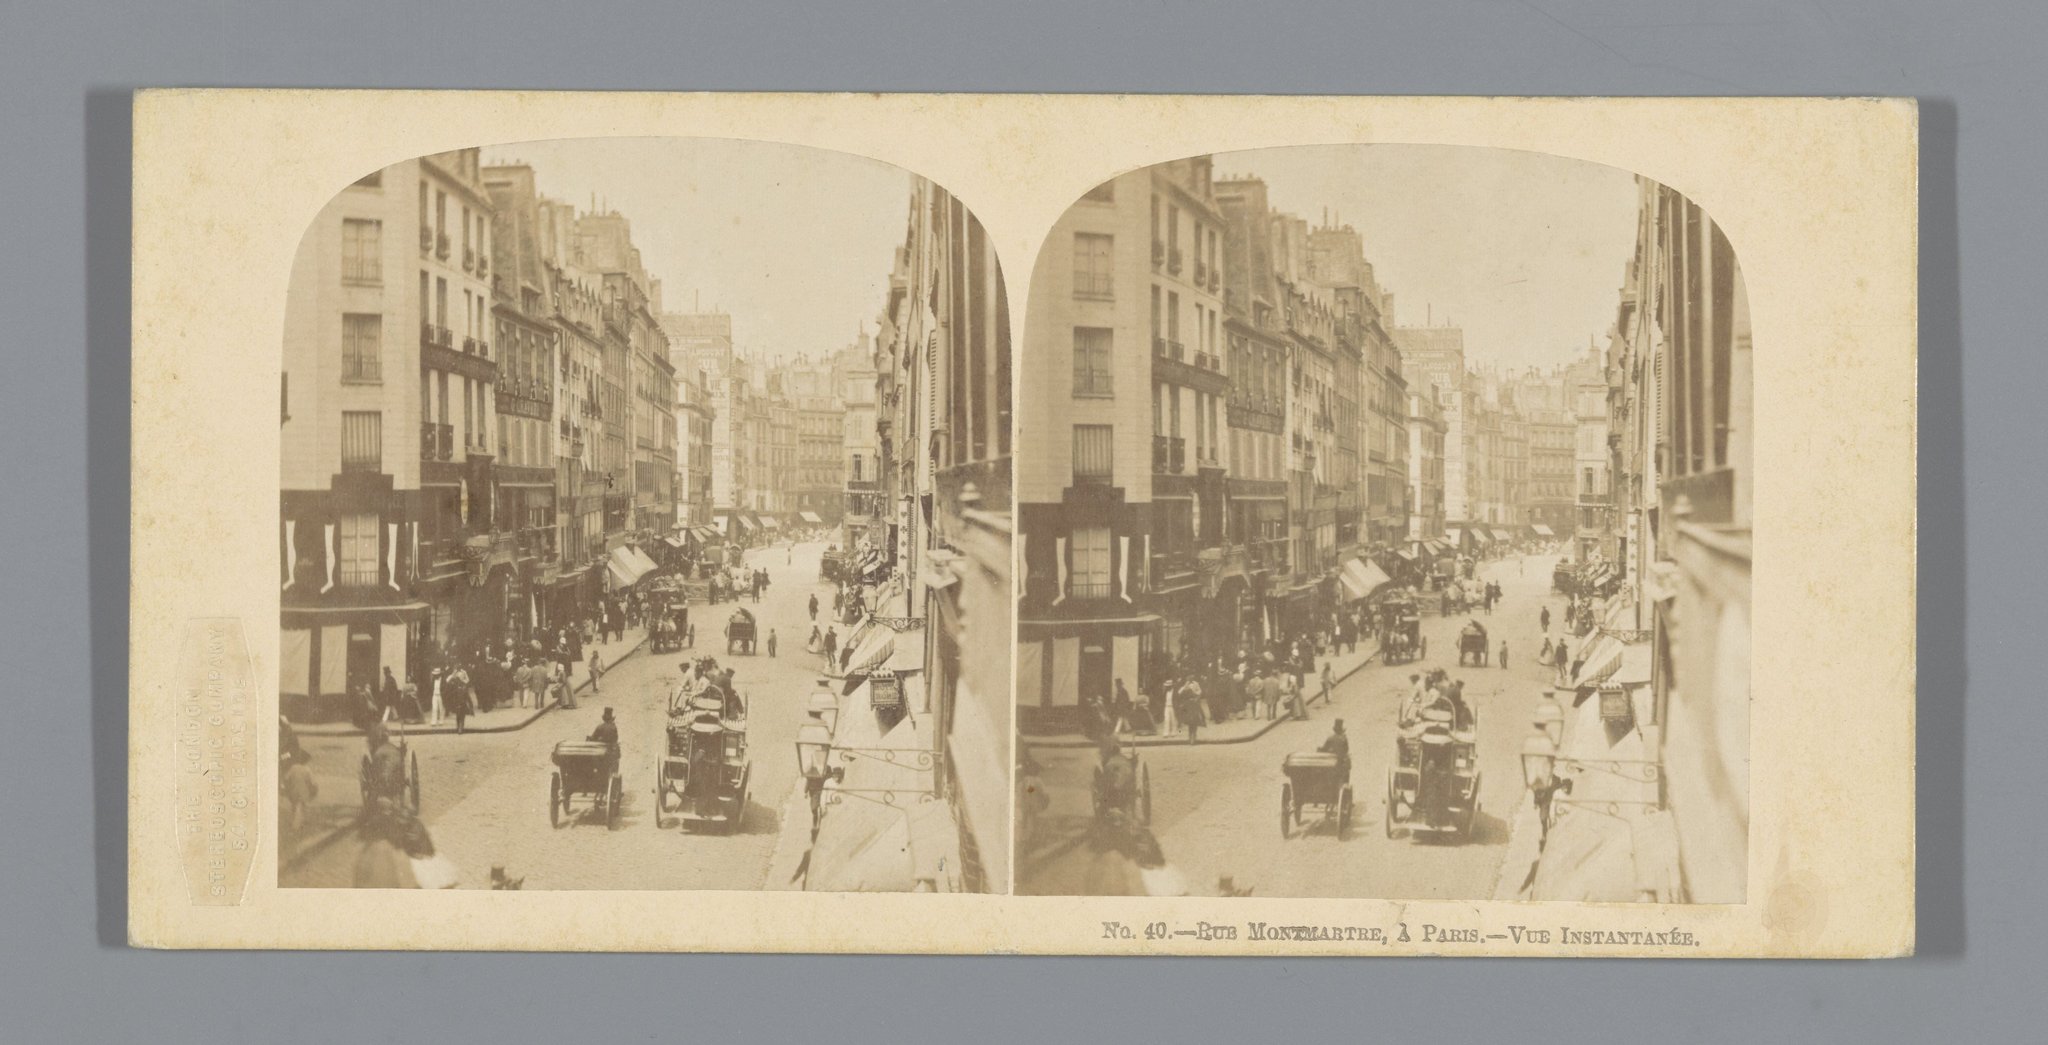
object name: stereograph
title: Rue Montmartre, à Paris-Vue instantanée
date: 1850-1875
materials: cardboard, photographic support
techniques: albumen print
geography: paris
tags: four-wheeled, animal-drawn vehicle, e.g.: cab, carriage, coach, street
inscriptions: number: ‘No. 40.’